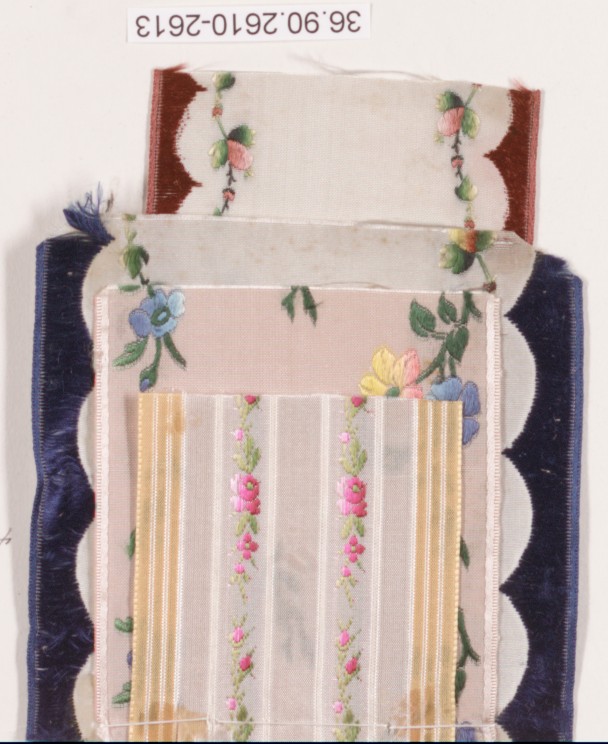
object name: ribbon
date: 1801-1900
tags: flowers